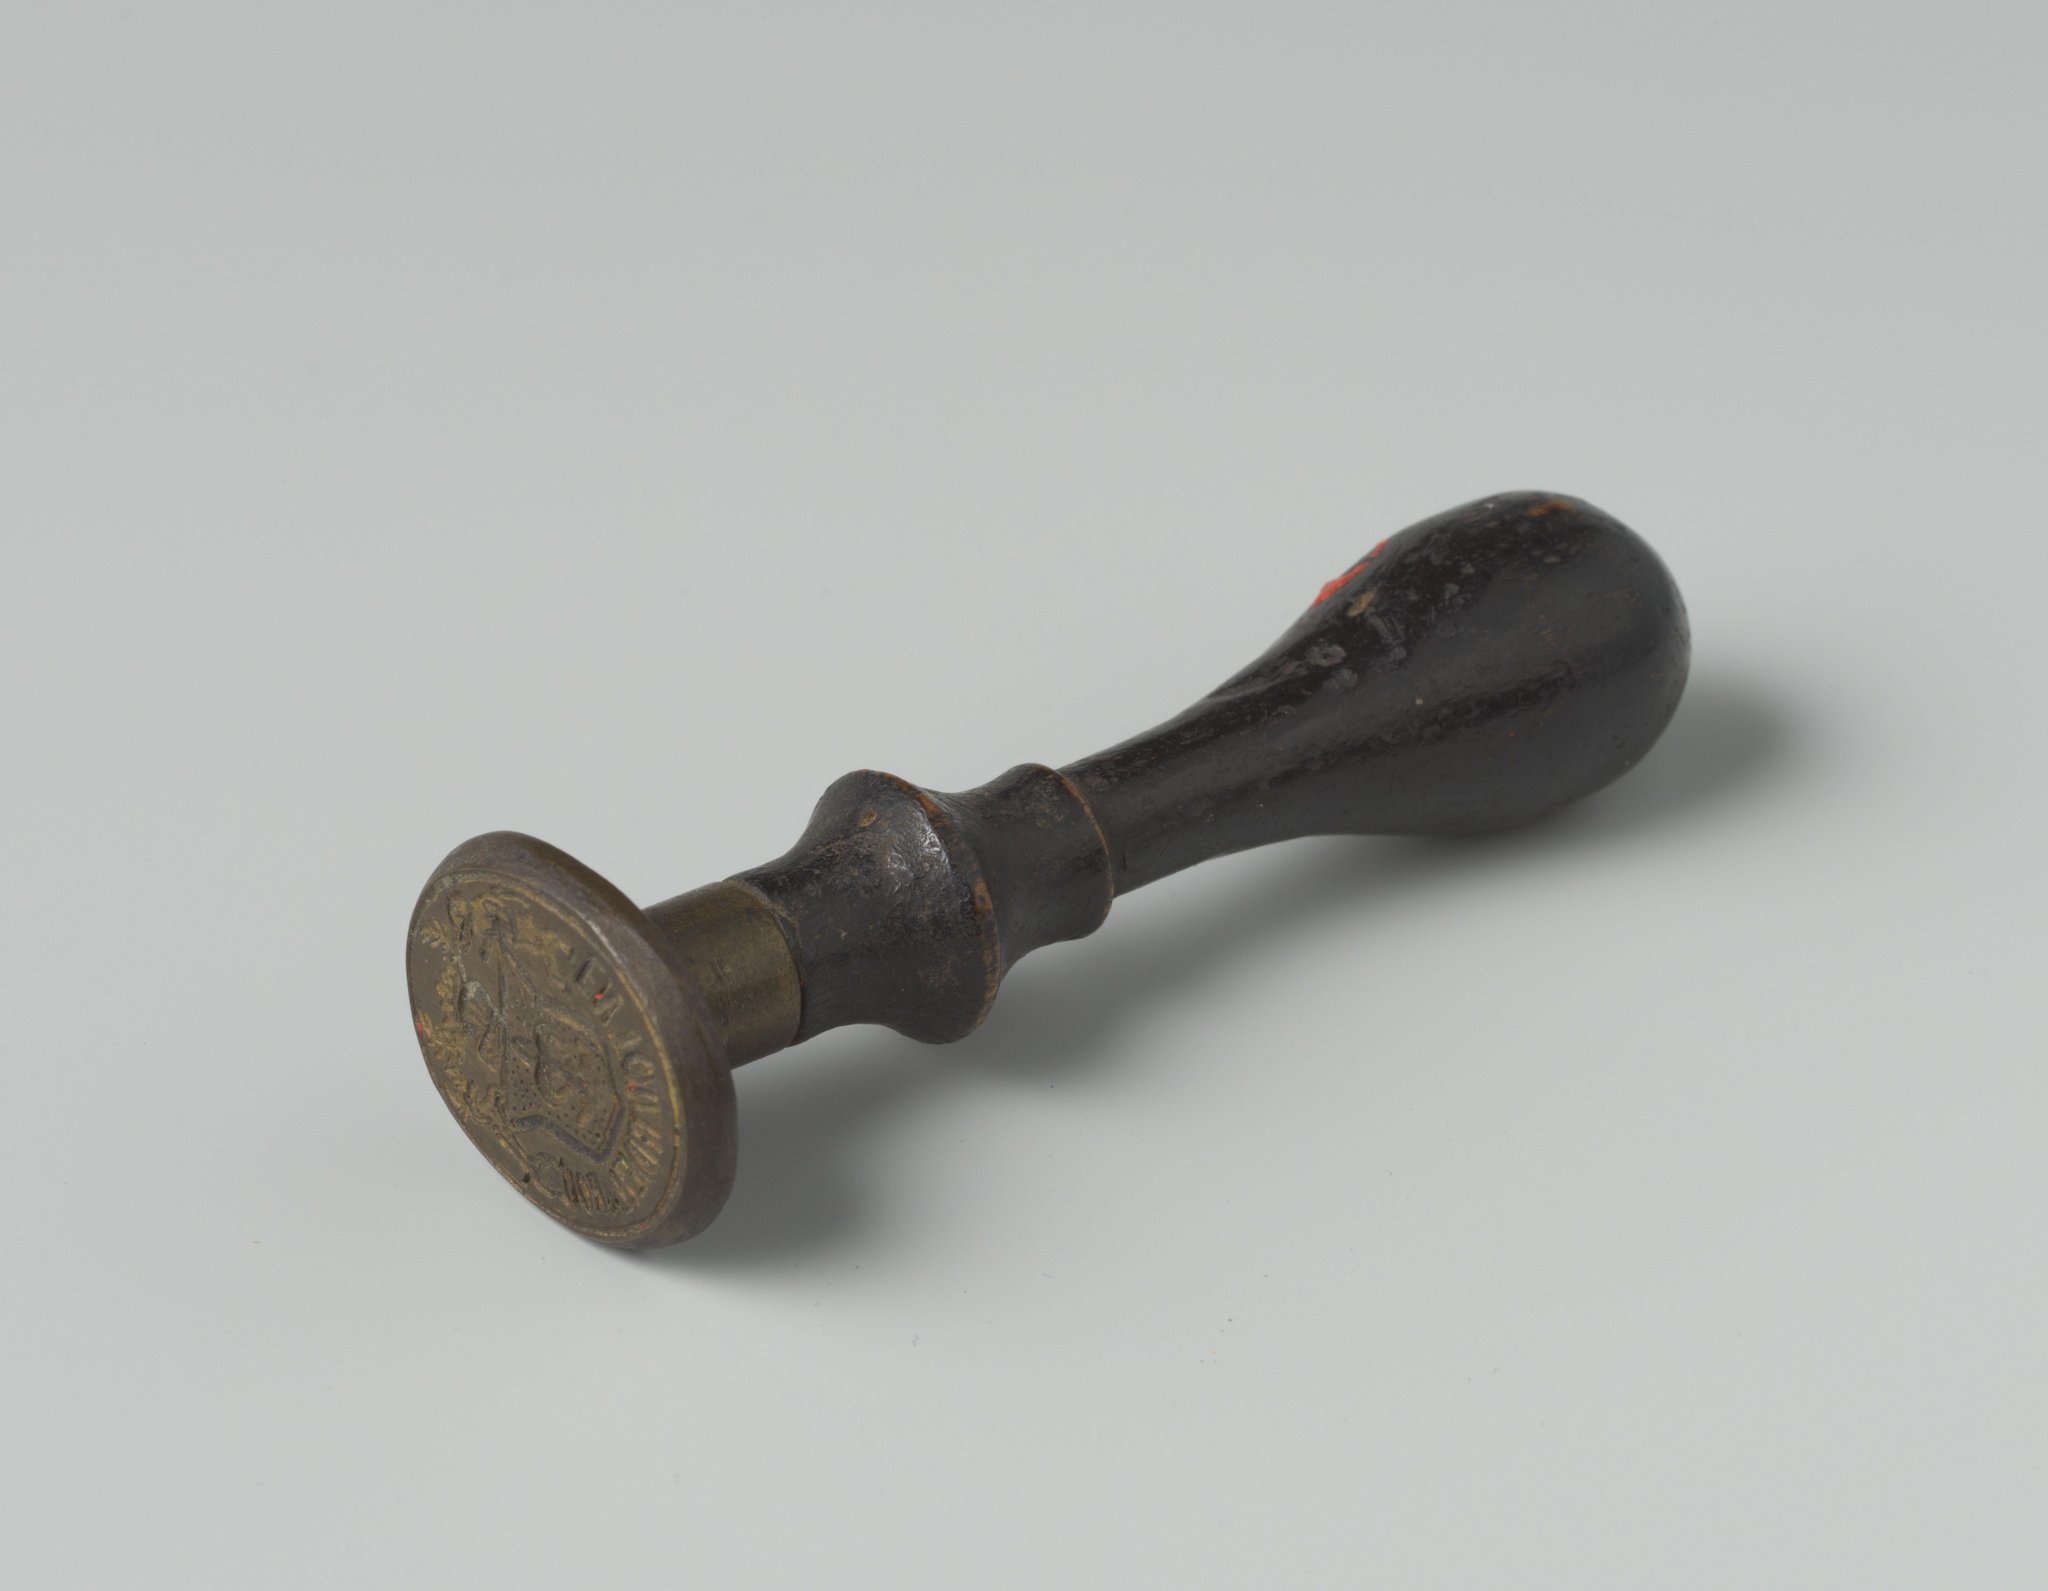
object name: zegelstempel, lakstempel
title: Zegelstempel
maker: Anonymous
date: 1800-1900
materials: copper, wood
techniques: engraving, turning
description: Zegelstempel van koper op een houten steel. Het stempel toont het wapen van de familie Swellengrebel.